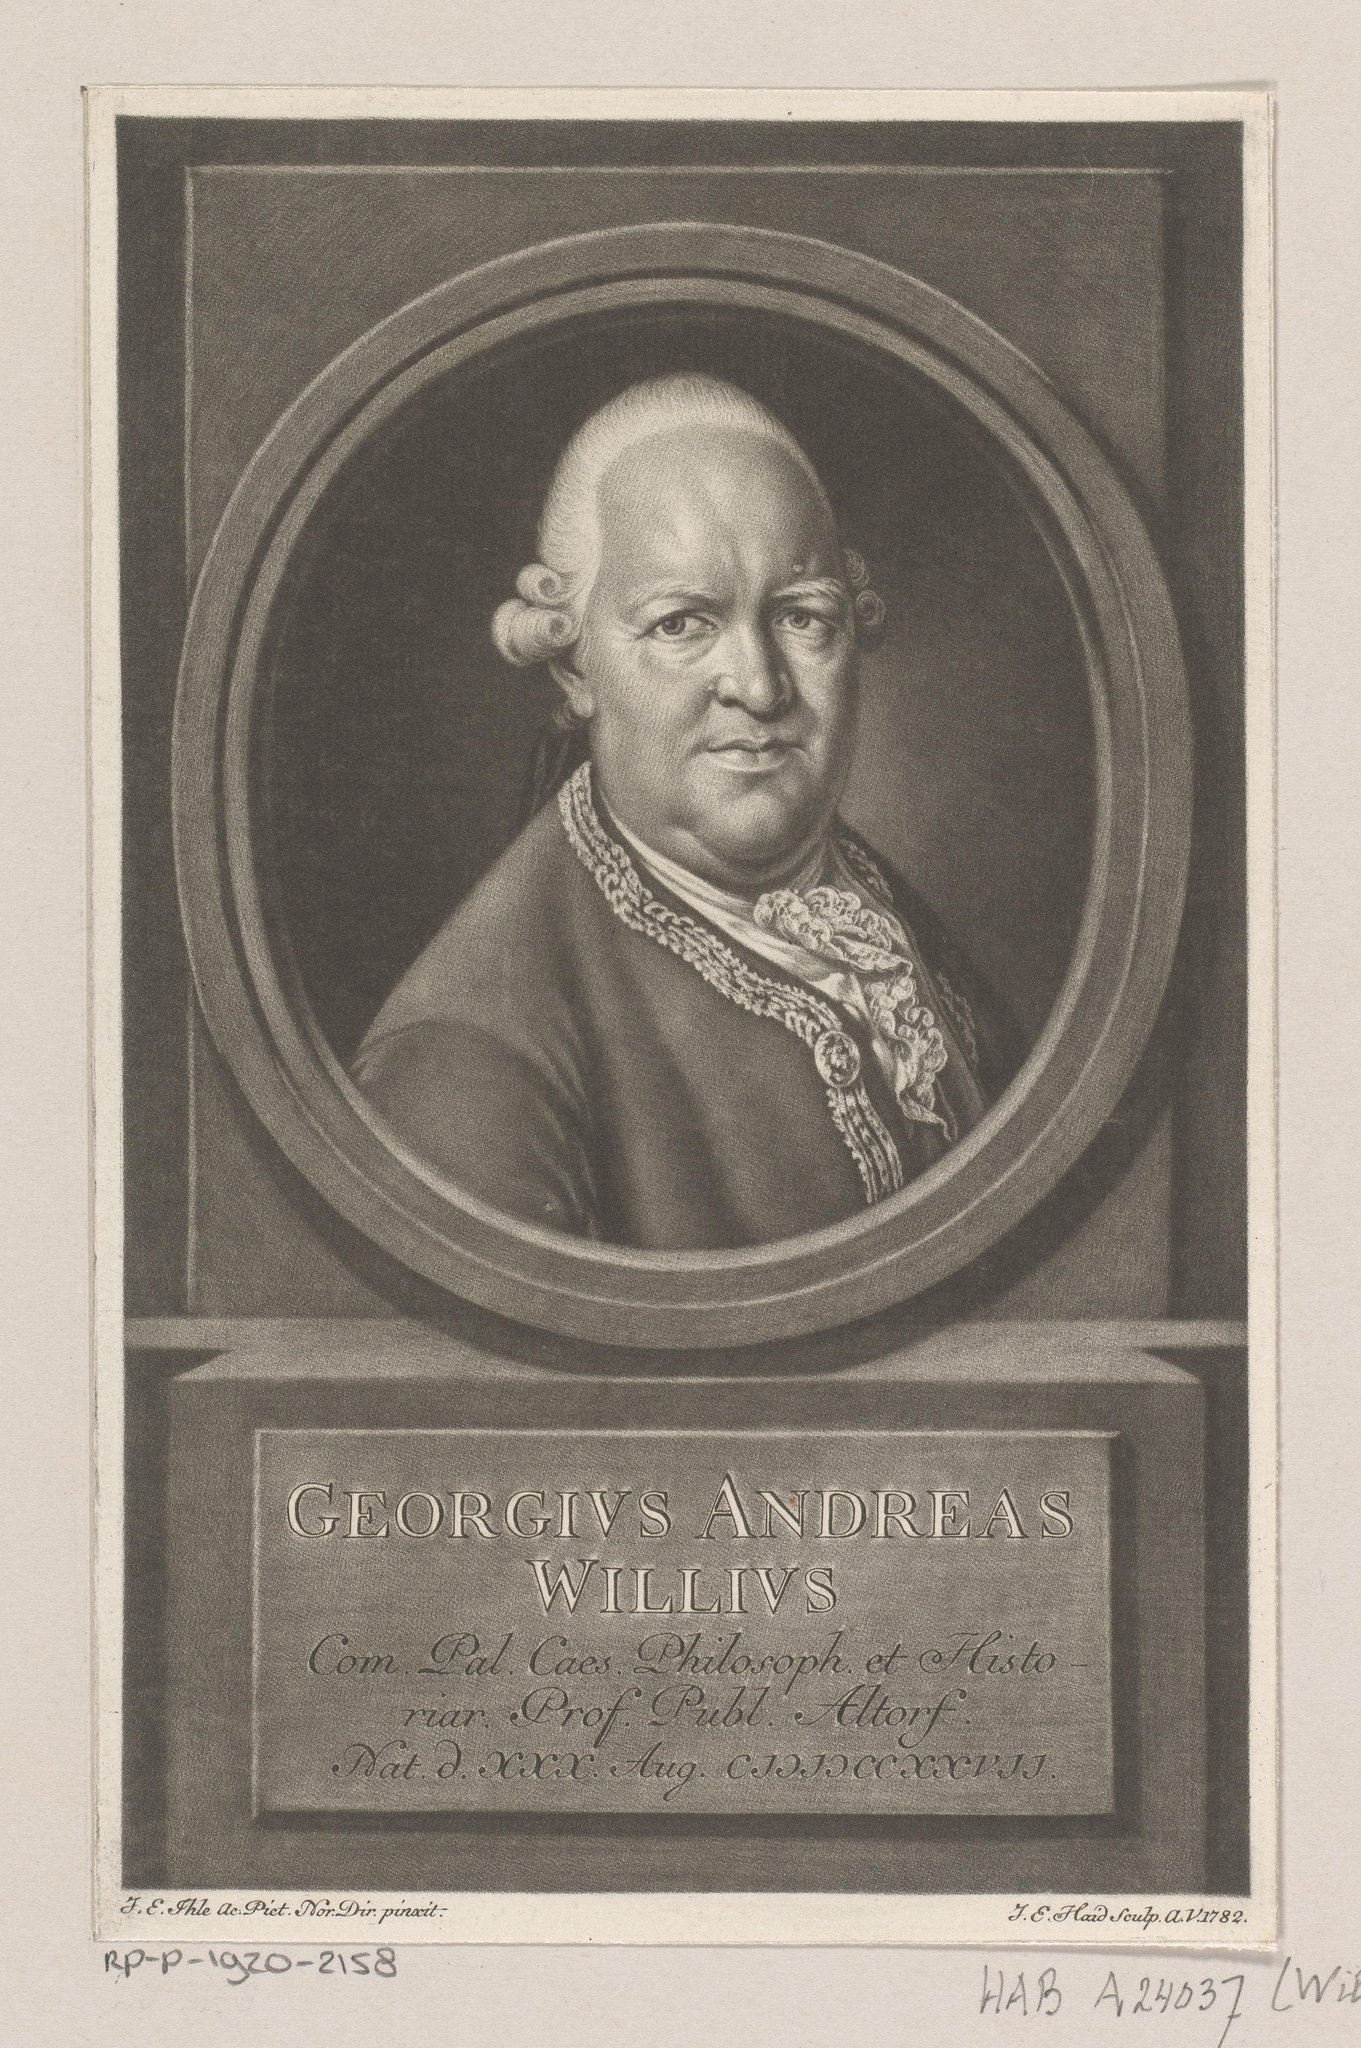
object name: print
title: Portret van Georg Andreas Will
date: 1782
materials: paper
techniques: mezzotint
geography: augsburg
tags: higher education, e.g.: teacher's college, historical persons, scholar, philosopher (+ portrait of scholar, scientist)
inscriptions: collector's mark: Lugt 2228